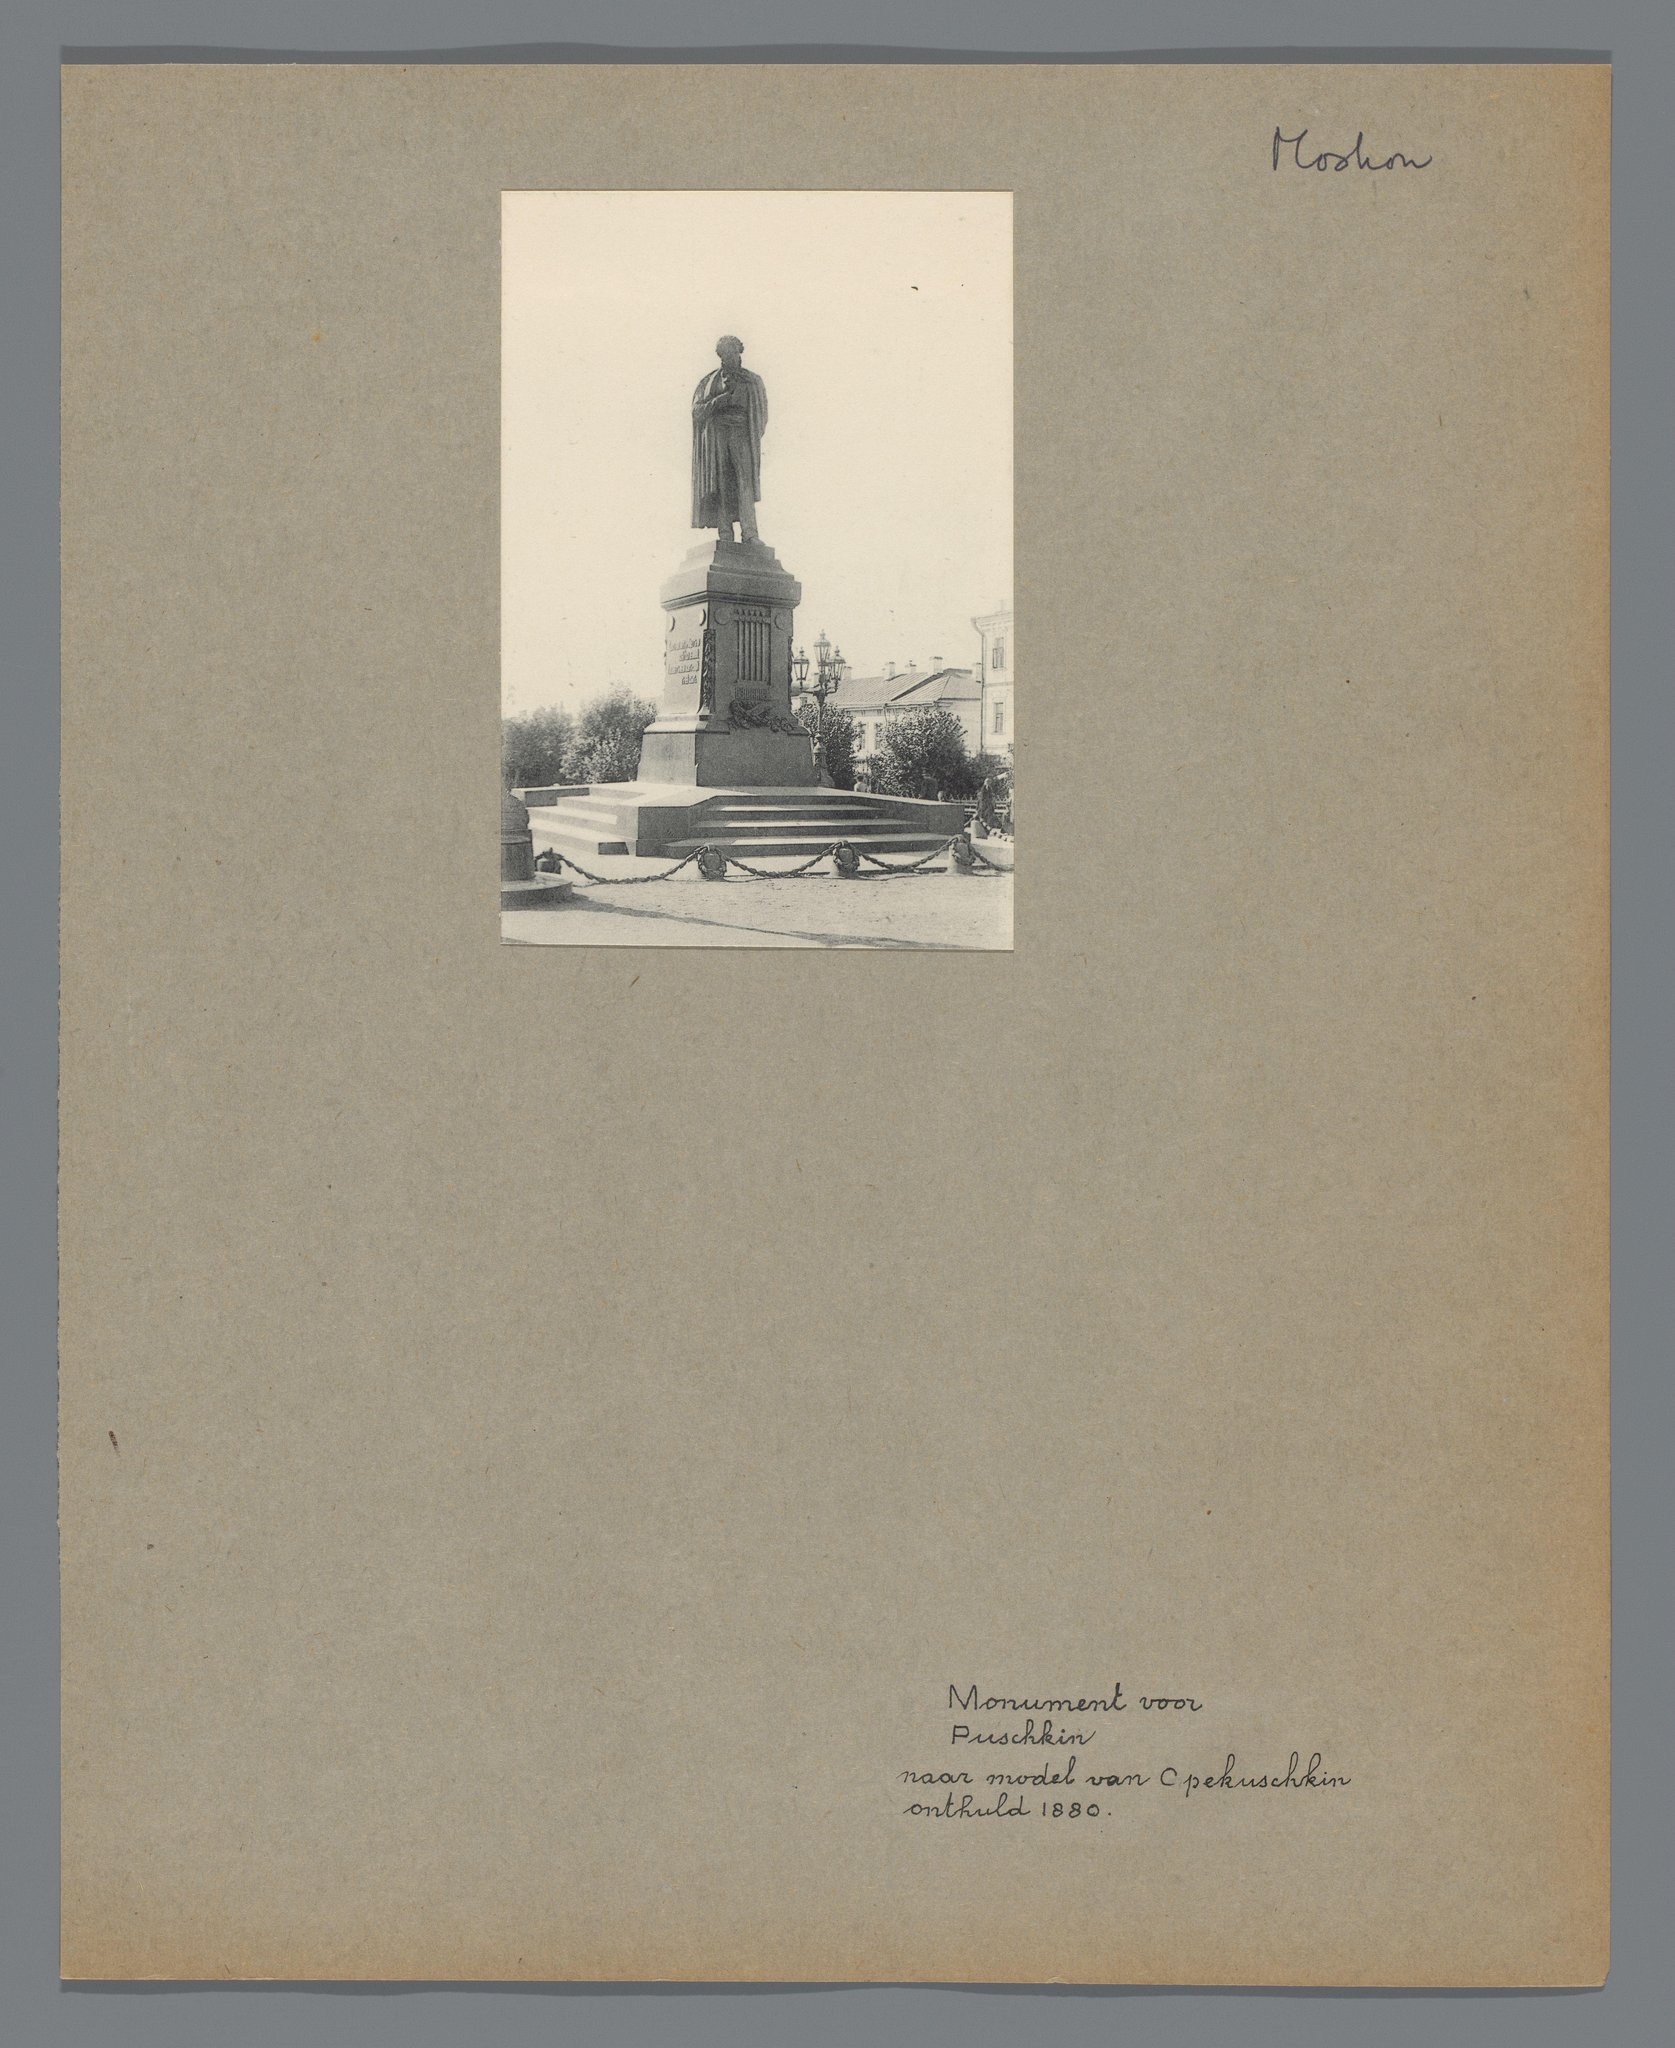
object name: photograph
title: Moskou. Monument voor Puschkin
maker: Anonymous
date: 1860-1925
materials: photographic support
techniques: photograph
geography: russia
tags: aleksandr sergeevic puskin